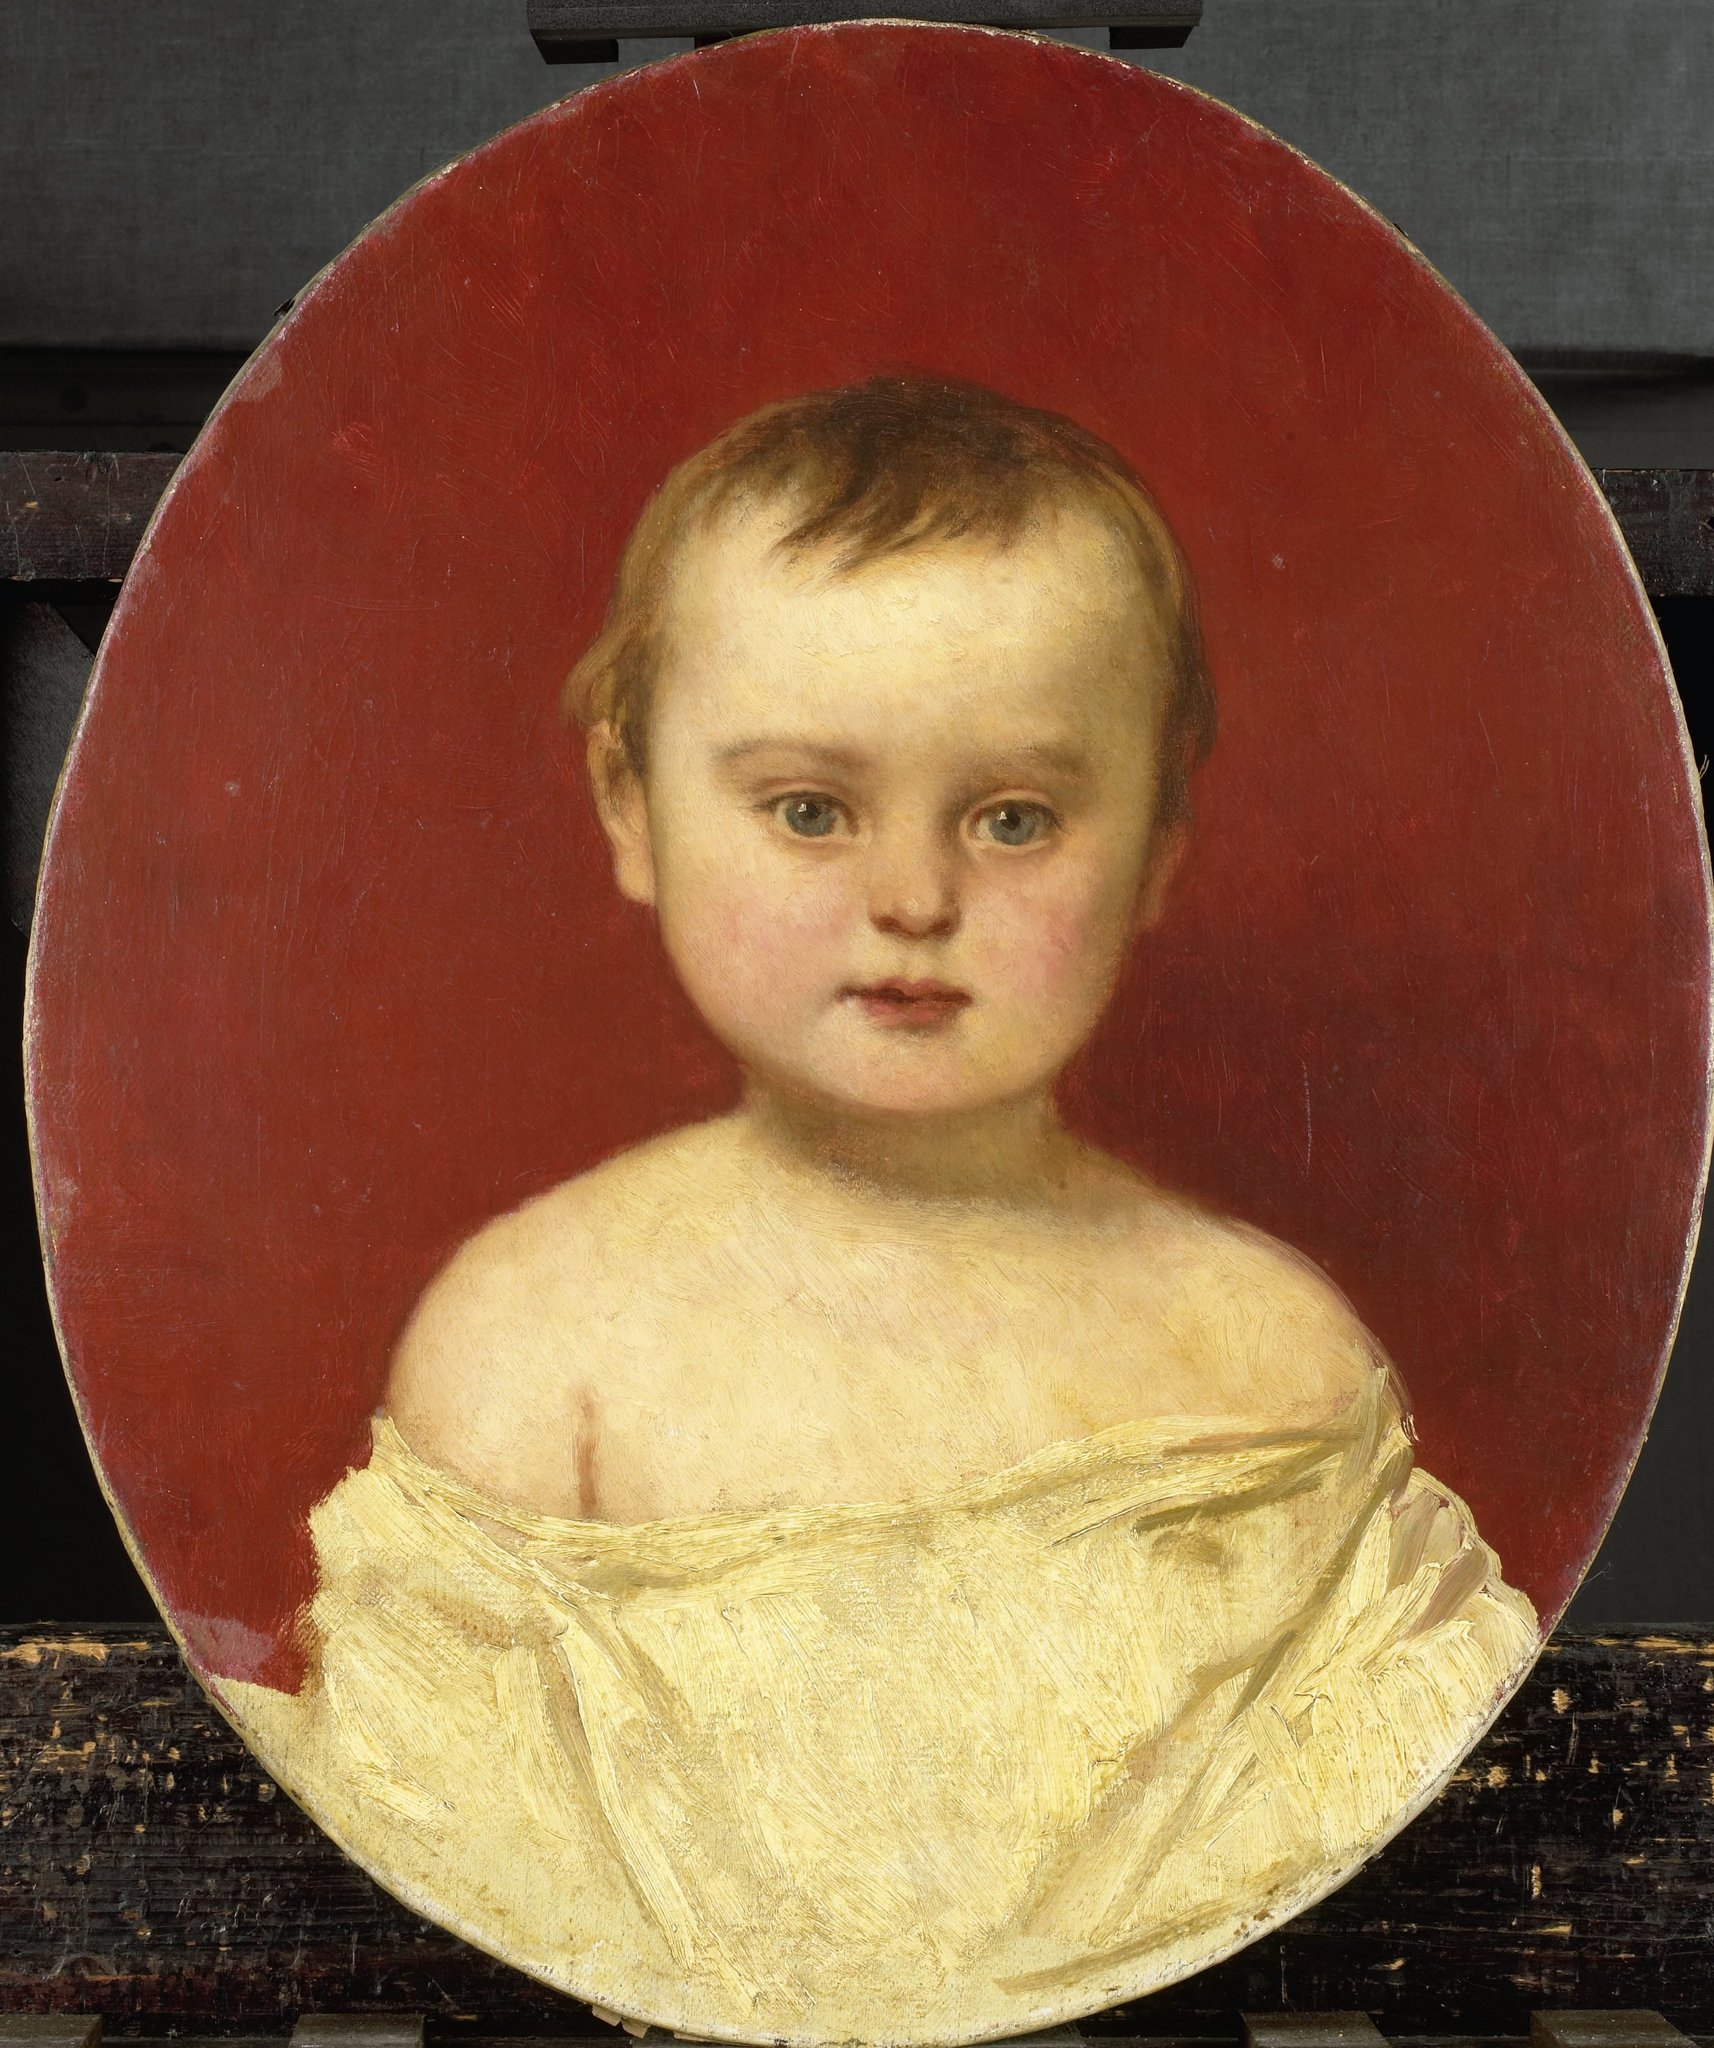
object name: painting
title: Henri Bernard van der Kolk at the Age of Two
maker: jaroslav cermak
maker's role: print maker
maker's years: 1831-1878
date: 1857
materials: canvas, oil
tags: historical persons, toddler (male)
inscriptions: date: ‘6 Juni 1857’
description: Kinderportret: portret van Henri Bernard van der Kolk op 2-jarige leeftijd.